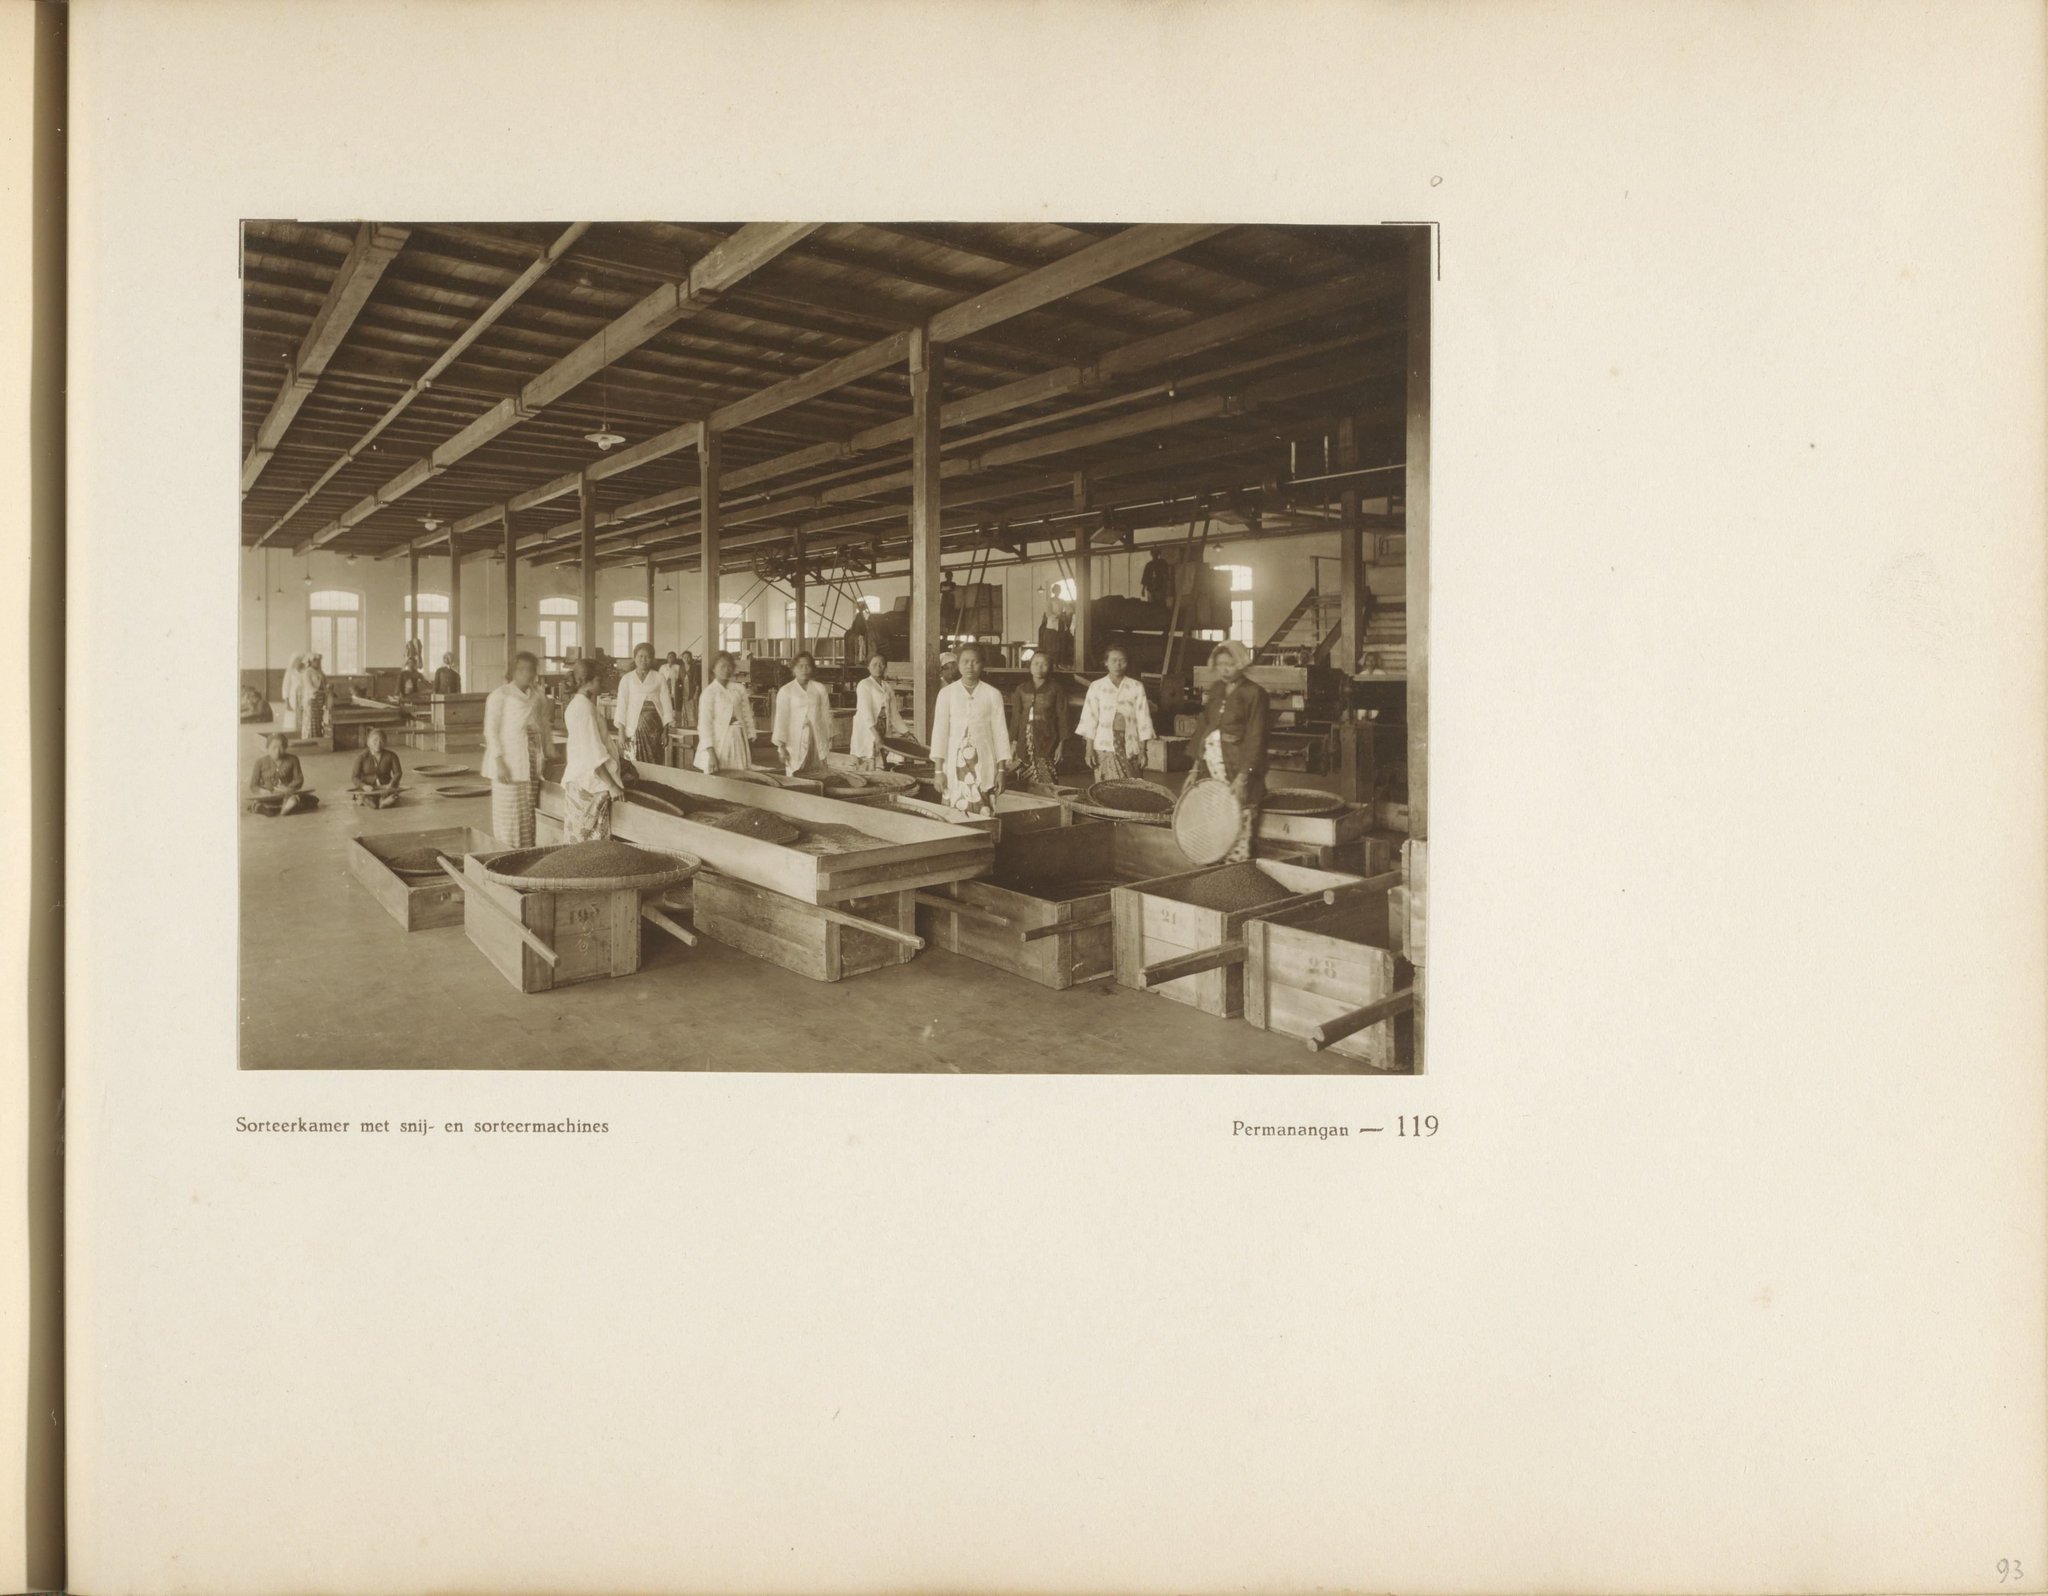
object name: photograph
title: Pagina 119 van fotoboek van de Algemeene Vereeniging van Rubberplanters ter Oostkust van Sumatra (A.V.R.O.S.)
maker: j.w. meyster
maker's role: fotograaf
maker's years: 1887-1945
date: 1924-1925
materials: paper, photographic support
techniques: printing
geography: sumatra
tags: factory-interior, machine shop, (non-fruit) products of plants or trees: rubber, machines, engines ~ crafts and industries (+ agricultural processes), tea (leaves), working class, labourers - aa - women, sumatra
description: Boekpagina met een foto van Indische vrouwen werkzaam in de sorteerkamer van een theefabriek te Permanangan. Onderdeel van een fotoboek van de Algemeene Vereeniging van Rubberplanters ter Oostkust van Sumatra (A.V.R.O.S.).